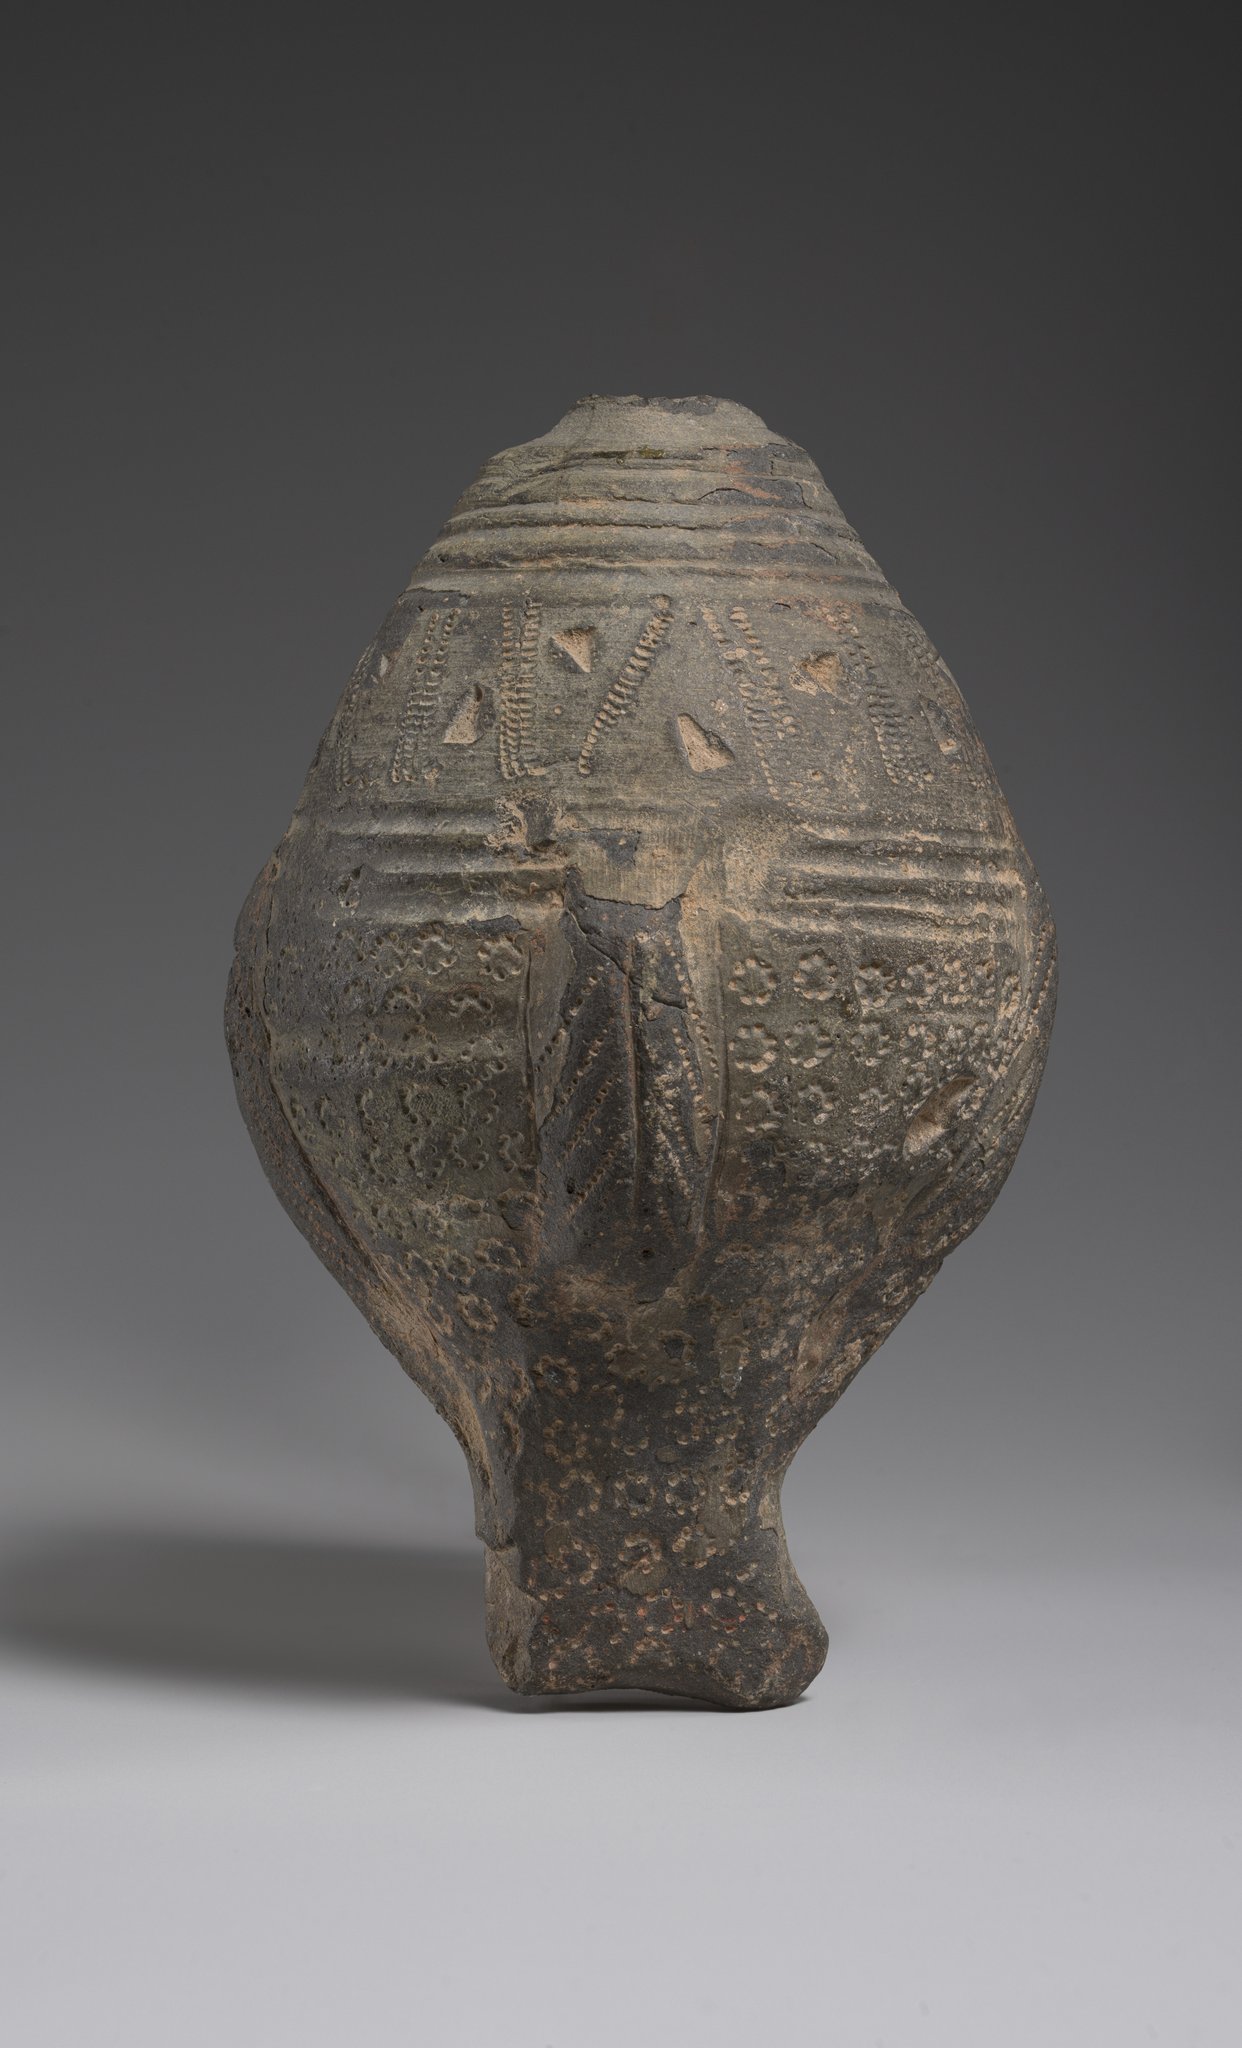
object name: vessel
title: Spheroconical Vessel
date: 1001-1200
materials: earthenware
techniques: incising, stamping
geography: iran